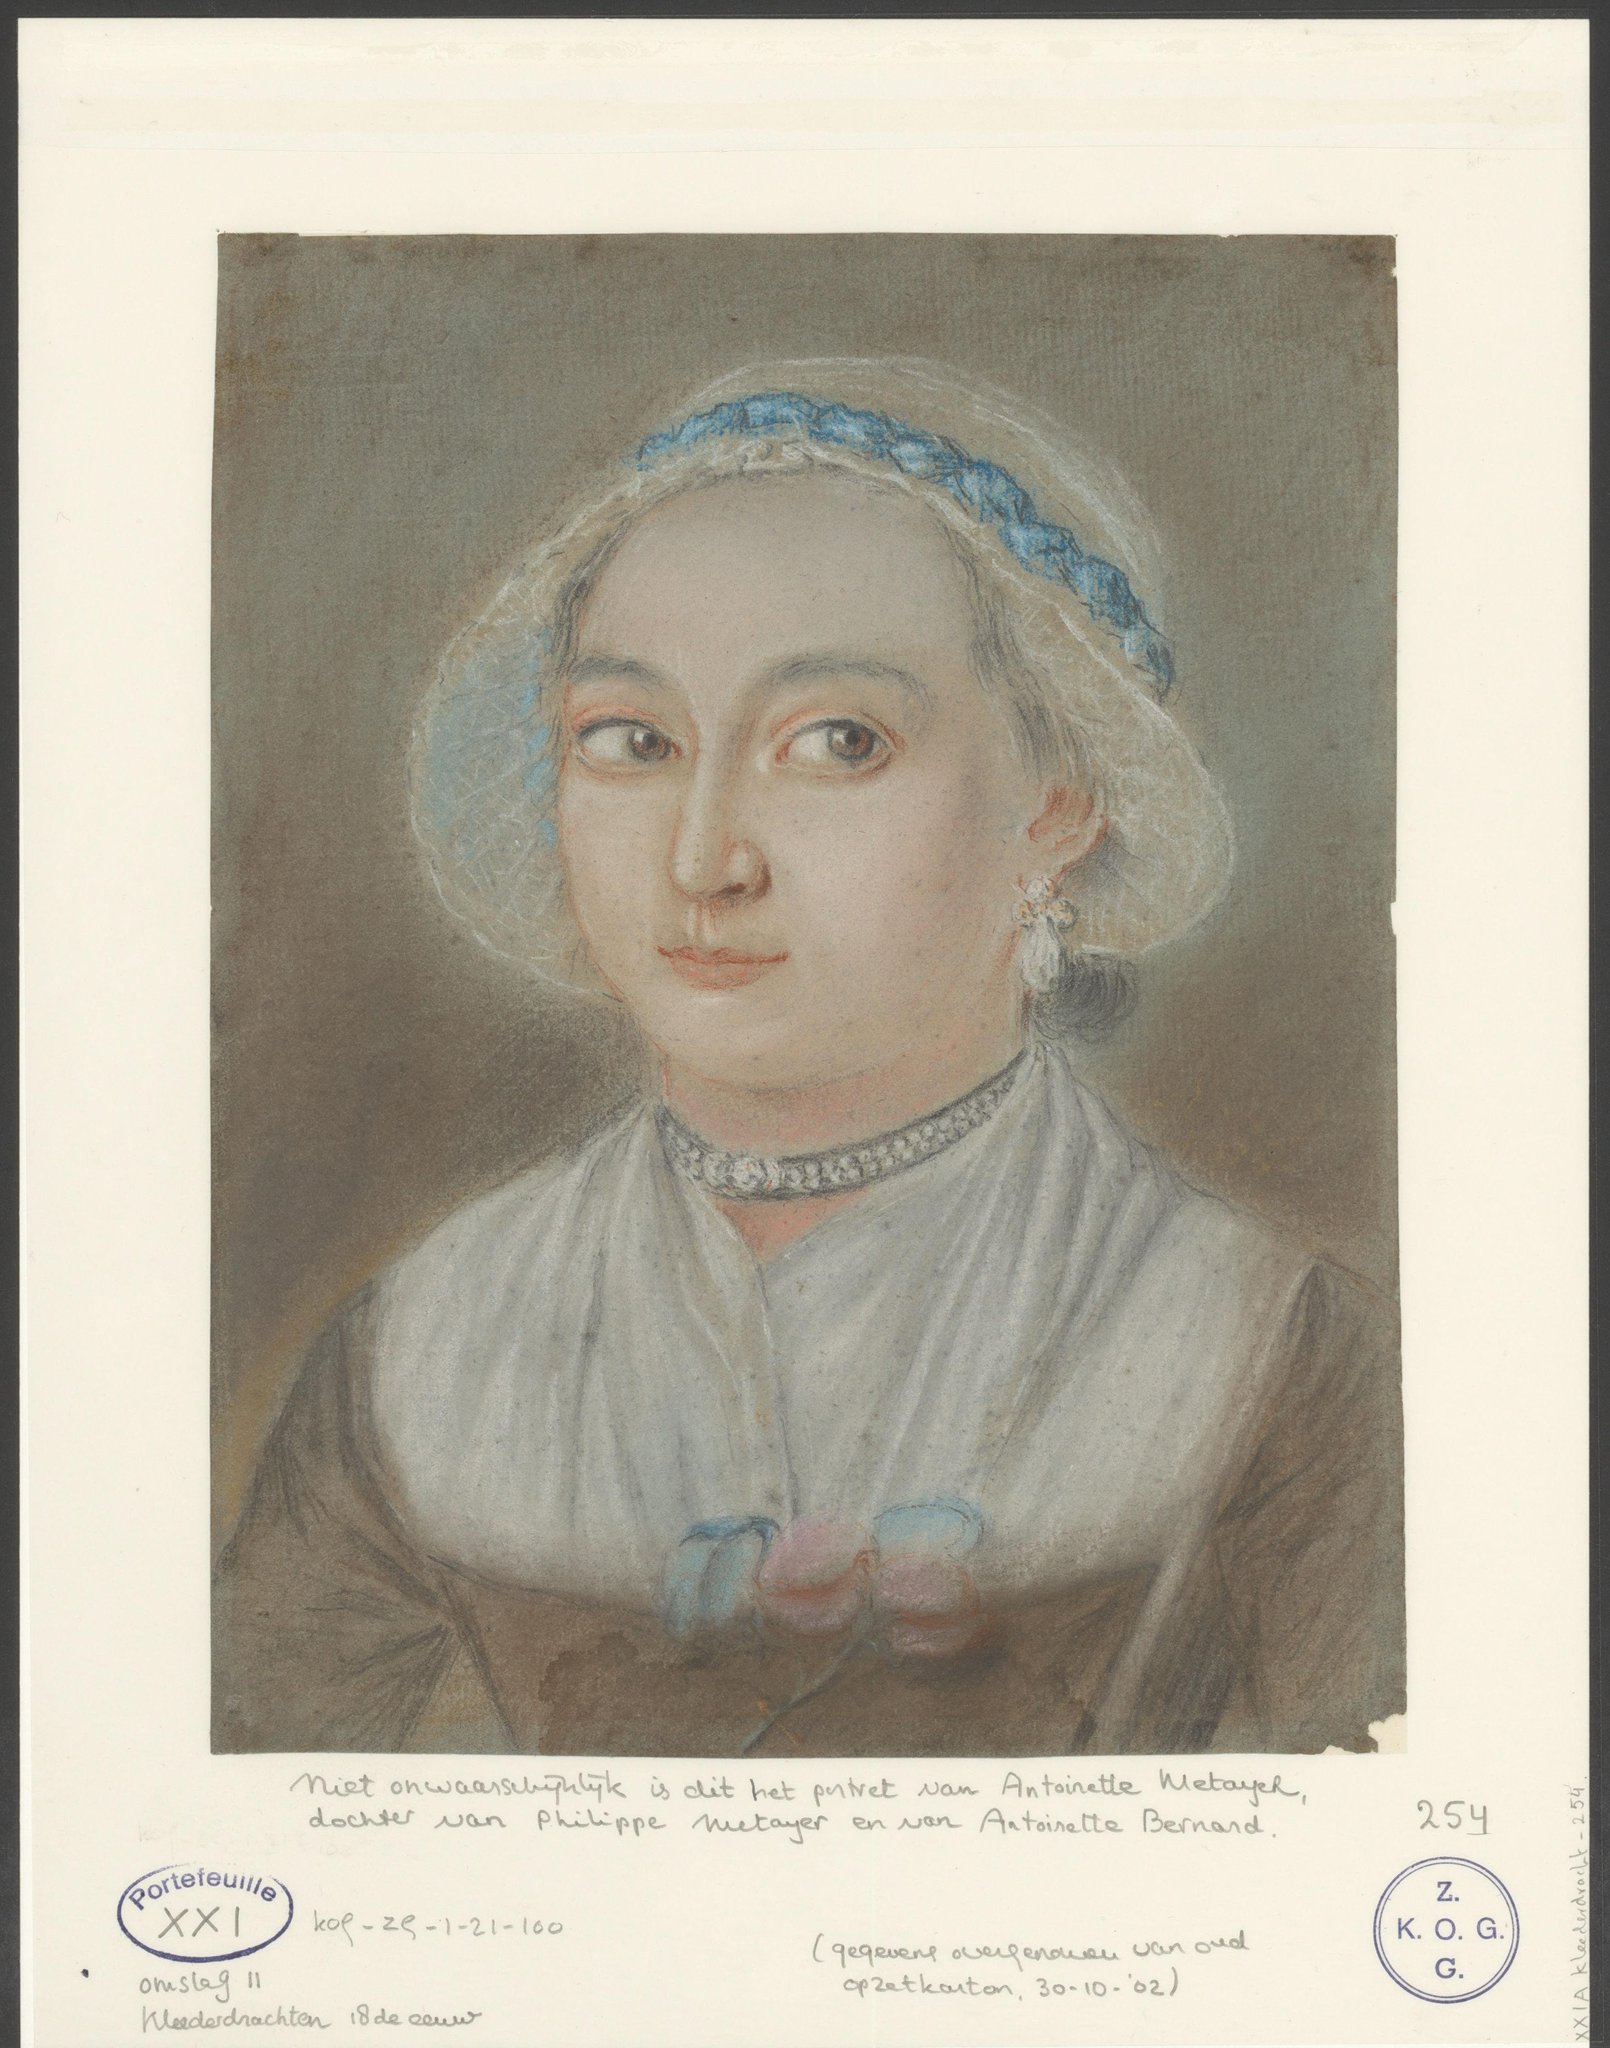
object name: drawing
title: Portret van een onbekende vrouw, mogelijk Antoinette Metayer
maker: Anonymous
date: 1747-1788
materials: paper, pastel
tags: historical persons not known by name - bb - woman, head-gear: cap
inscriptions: stamp, collector's mark: Lugt 1641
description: Portret van een onbekende jonge vrouw, mogelijk Antoinette Metayer. Zij was de dochter van Philippe Metayer. Op het hoofd een muts afgezet met kloskant. Onderwerpsrubrieken binnen de Atlas Zeden en Gewoonten: Zeden en Gewoonten in Engeren Zin, De Kleeding, Kleederdrachten (tijdvakken), De 18de eeuw (de revolutietijd). Mannen en vrouwen.